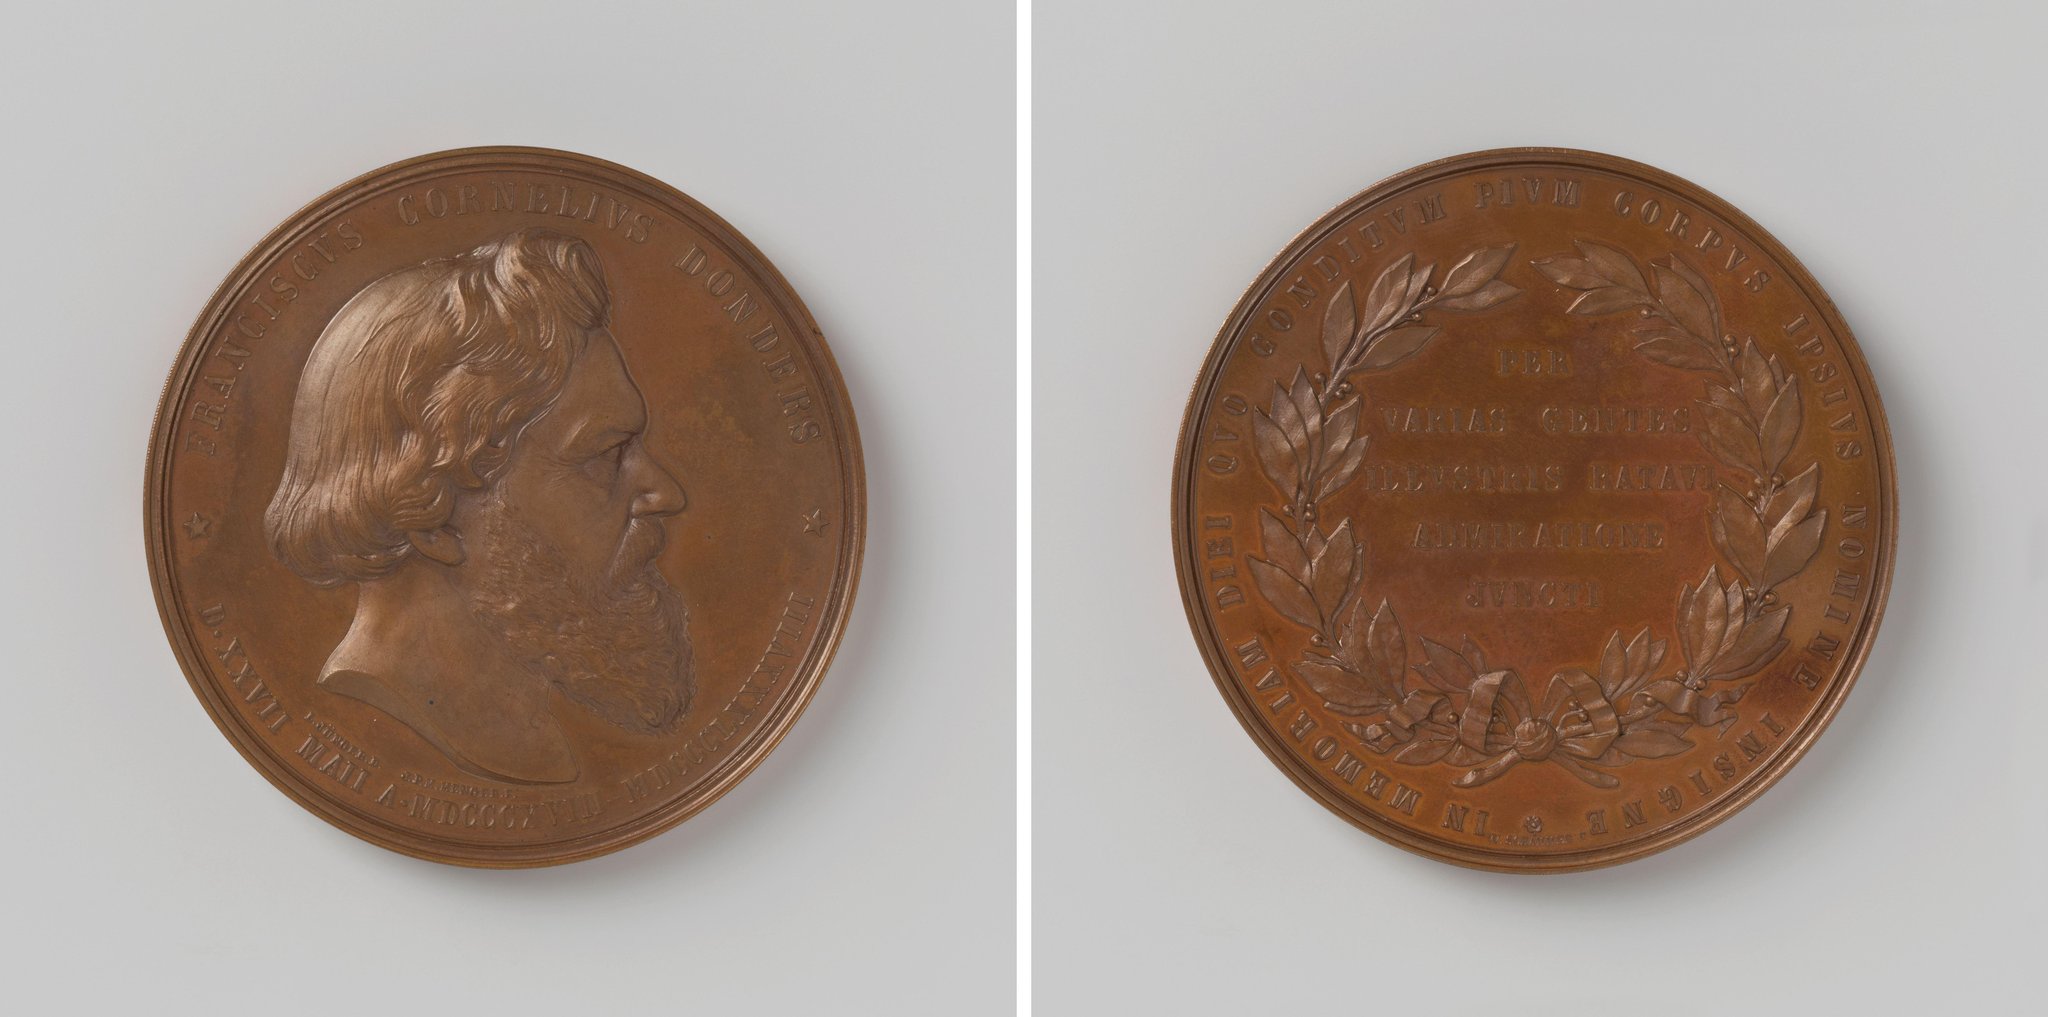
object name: honorary medal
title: Franciscus Cornelis Donders, penning geslagen ter ere van zijn zeventigste verjaardag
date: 1888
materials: bronze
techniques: striking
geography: netherlands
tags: utrecht, netherlands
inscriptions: date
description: Bronzen penning. Voorzijde: mannenkop in profiel naar rechts + randschrift en twee sterren links en rechts. Keerzijde: Opschrift binnen lauwerkrans en randschrift. Gemerkt; op zijkant: mercuriusstaf. Randschrift voorzijde: FRANCISCVS CORNELVS DONDERS. DXXVII MAII A. MDCCCXVIII. MDCCCLXXXVIII. Opschrift keerzijde: PER / VARIAS / GENTES / ILLVSTRIS / BATAVI / ADMIRHTIONE / JUNCTI. + (randschrift): IN / MEMORIAM / DIEI / QVO / CONDITVM PIVM CORPVS / IPSIVS / NOMINE / INSIGNE.